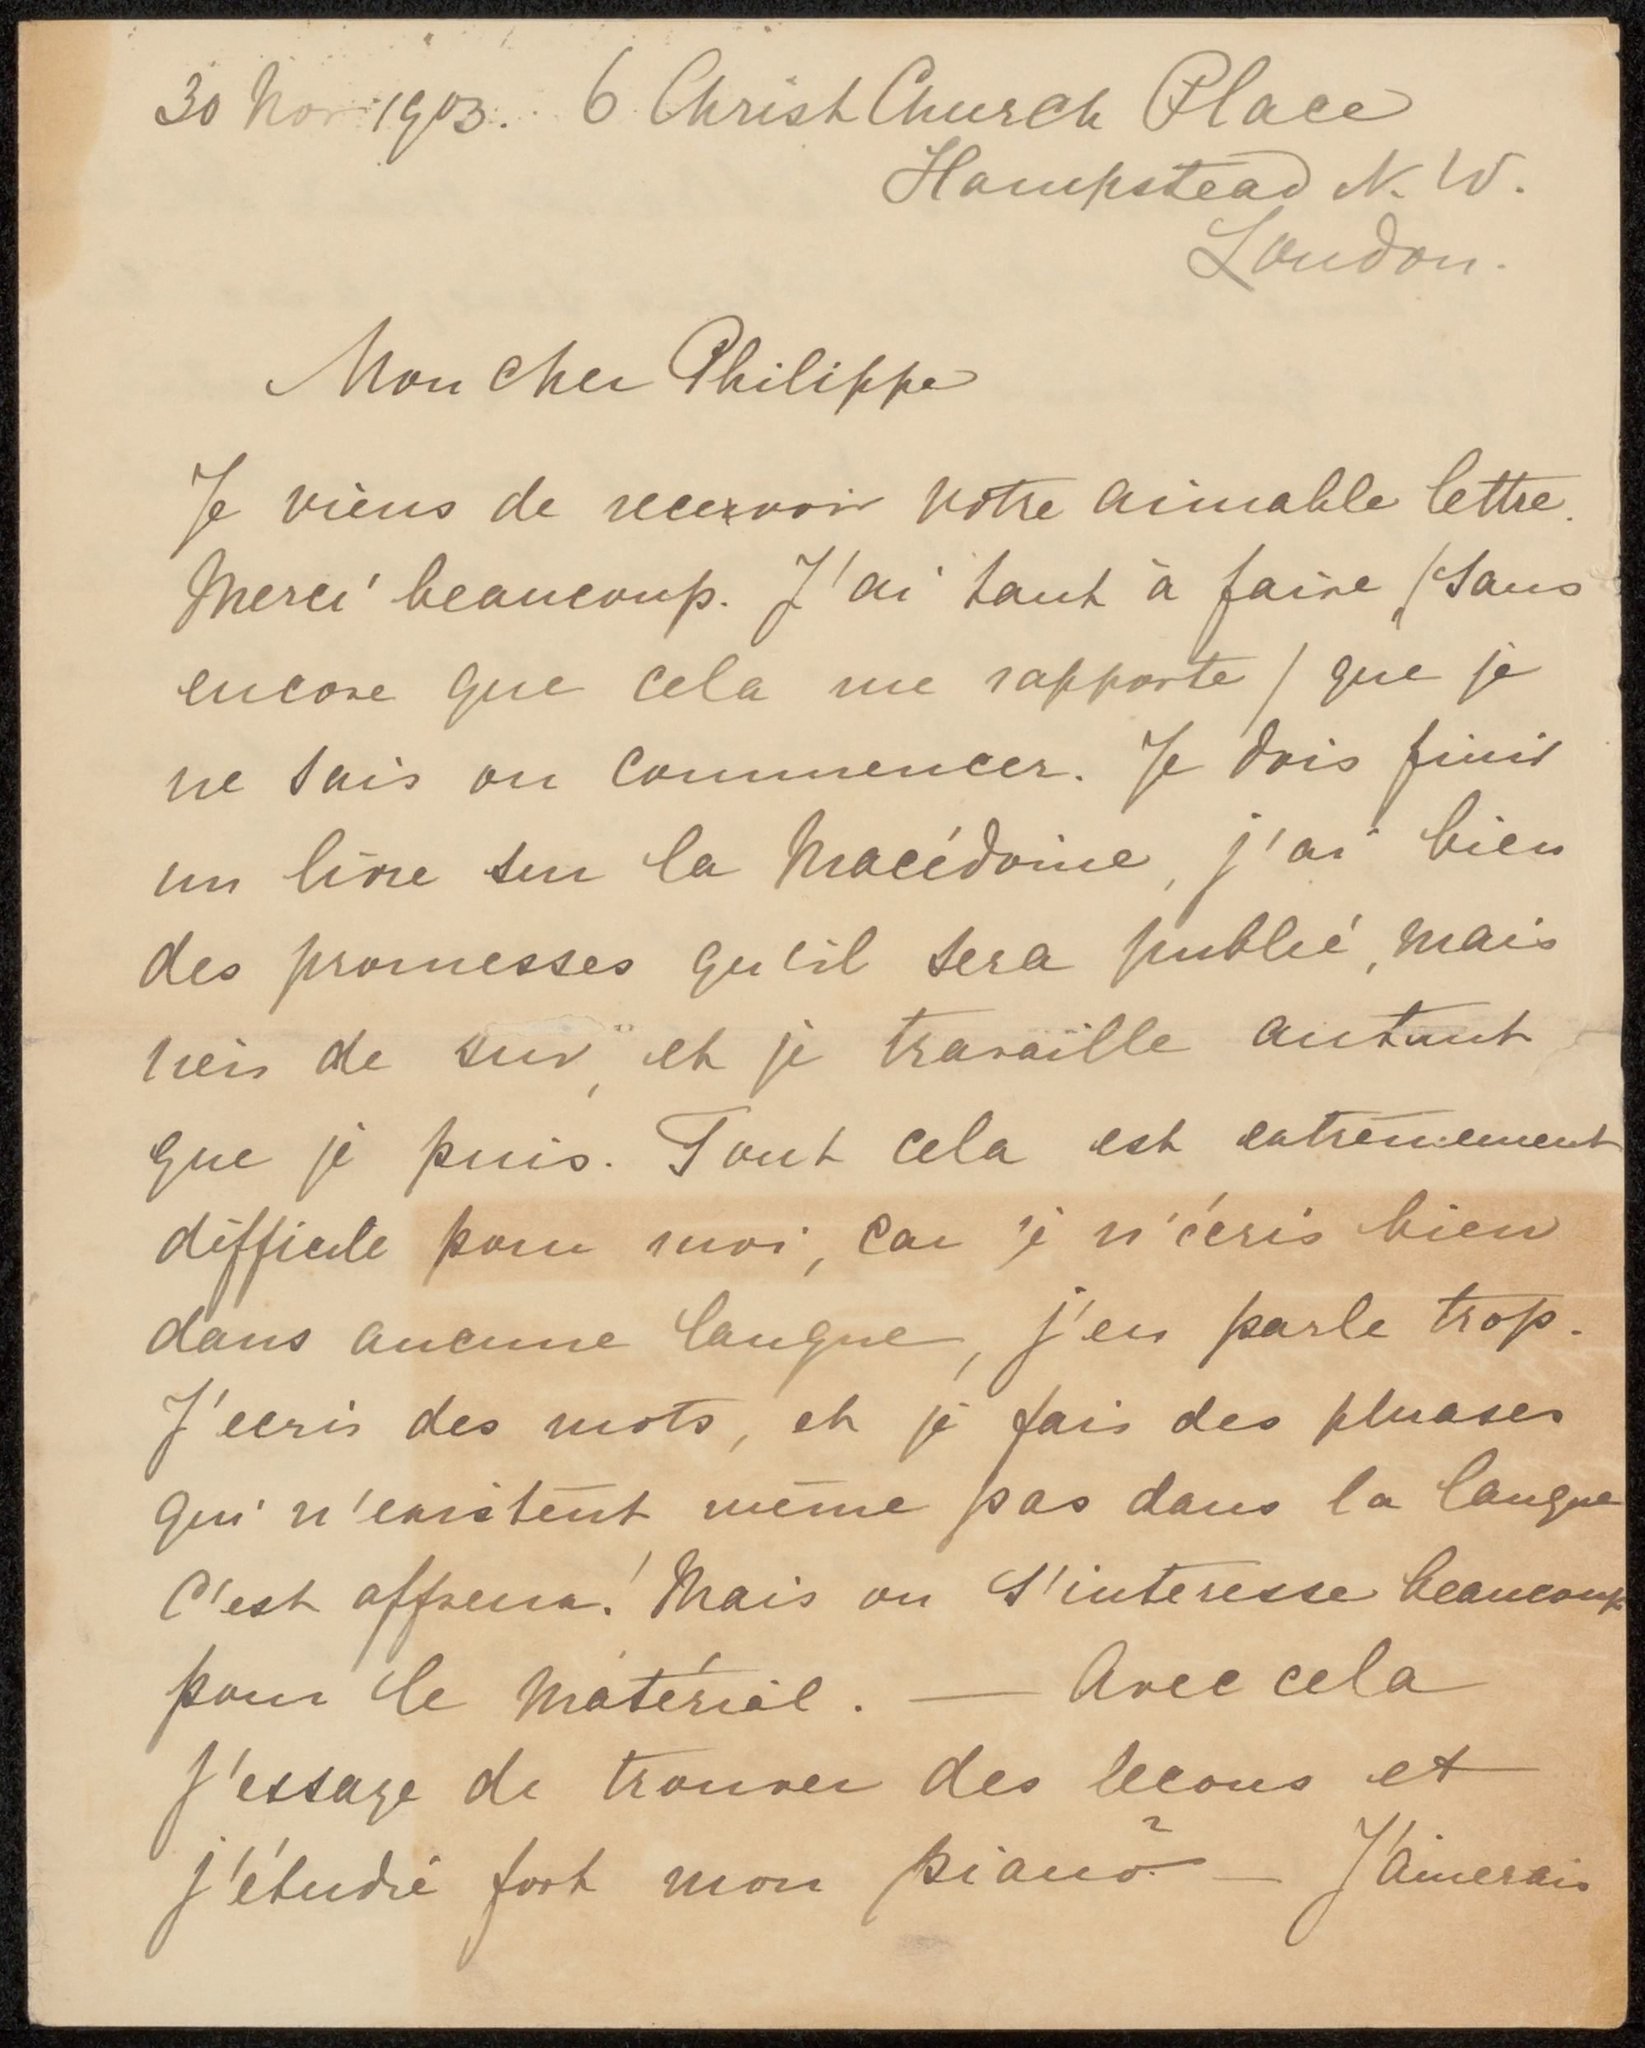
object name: letter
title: Brief aan Philip Zilcken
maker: ernestine hadkinson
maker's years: 1863-1928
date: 1903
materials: ink, paper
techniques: pen, writing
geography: hampstead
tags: the hague, painter, print maker, draughtsman, jozef israëls, elbert jan van wisselingh, philip zilcken, sculpture, exhibition ~ art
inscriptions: collector's mark: ‘RPK’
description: Vormt samen met RP-D-1982-43-HADKINSON(E.)-11B een doorlopende brief.